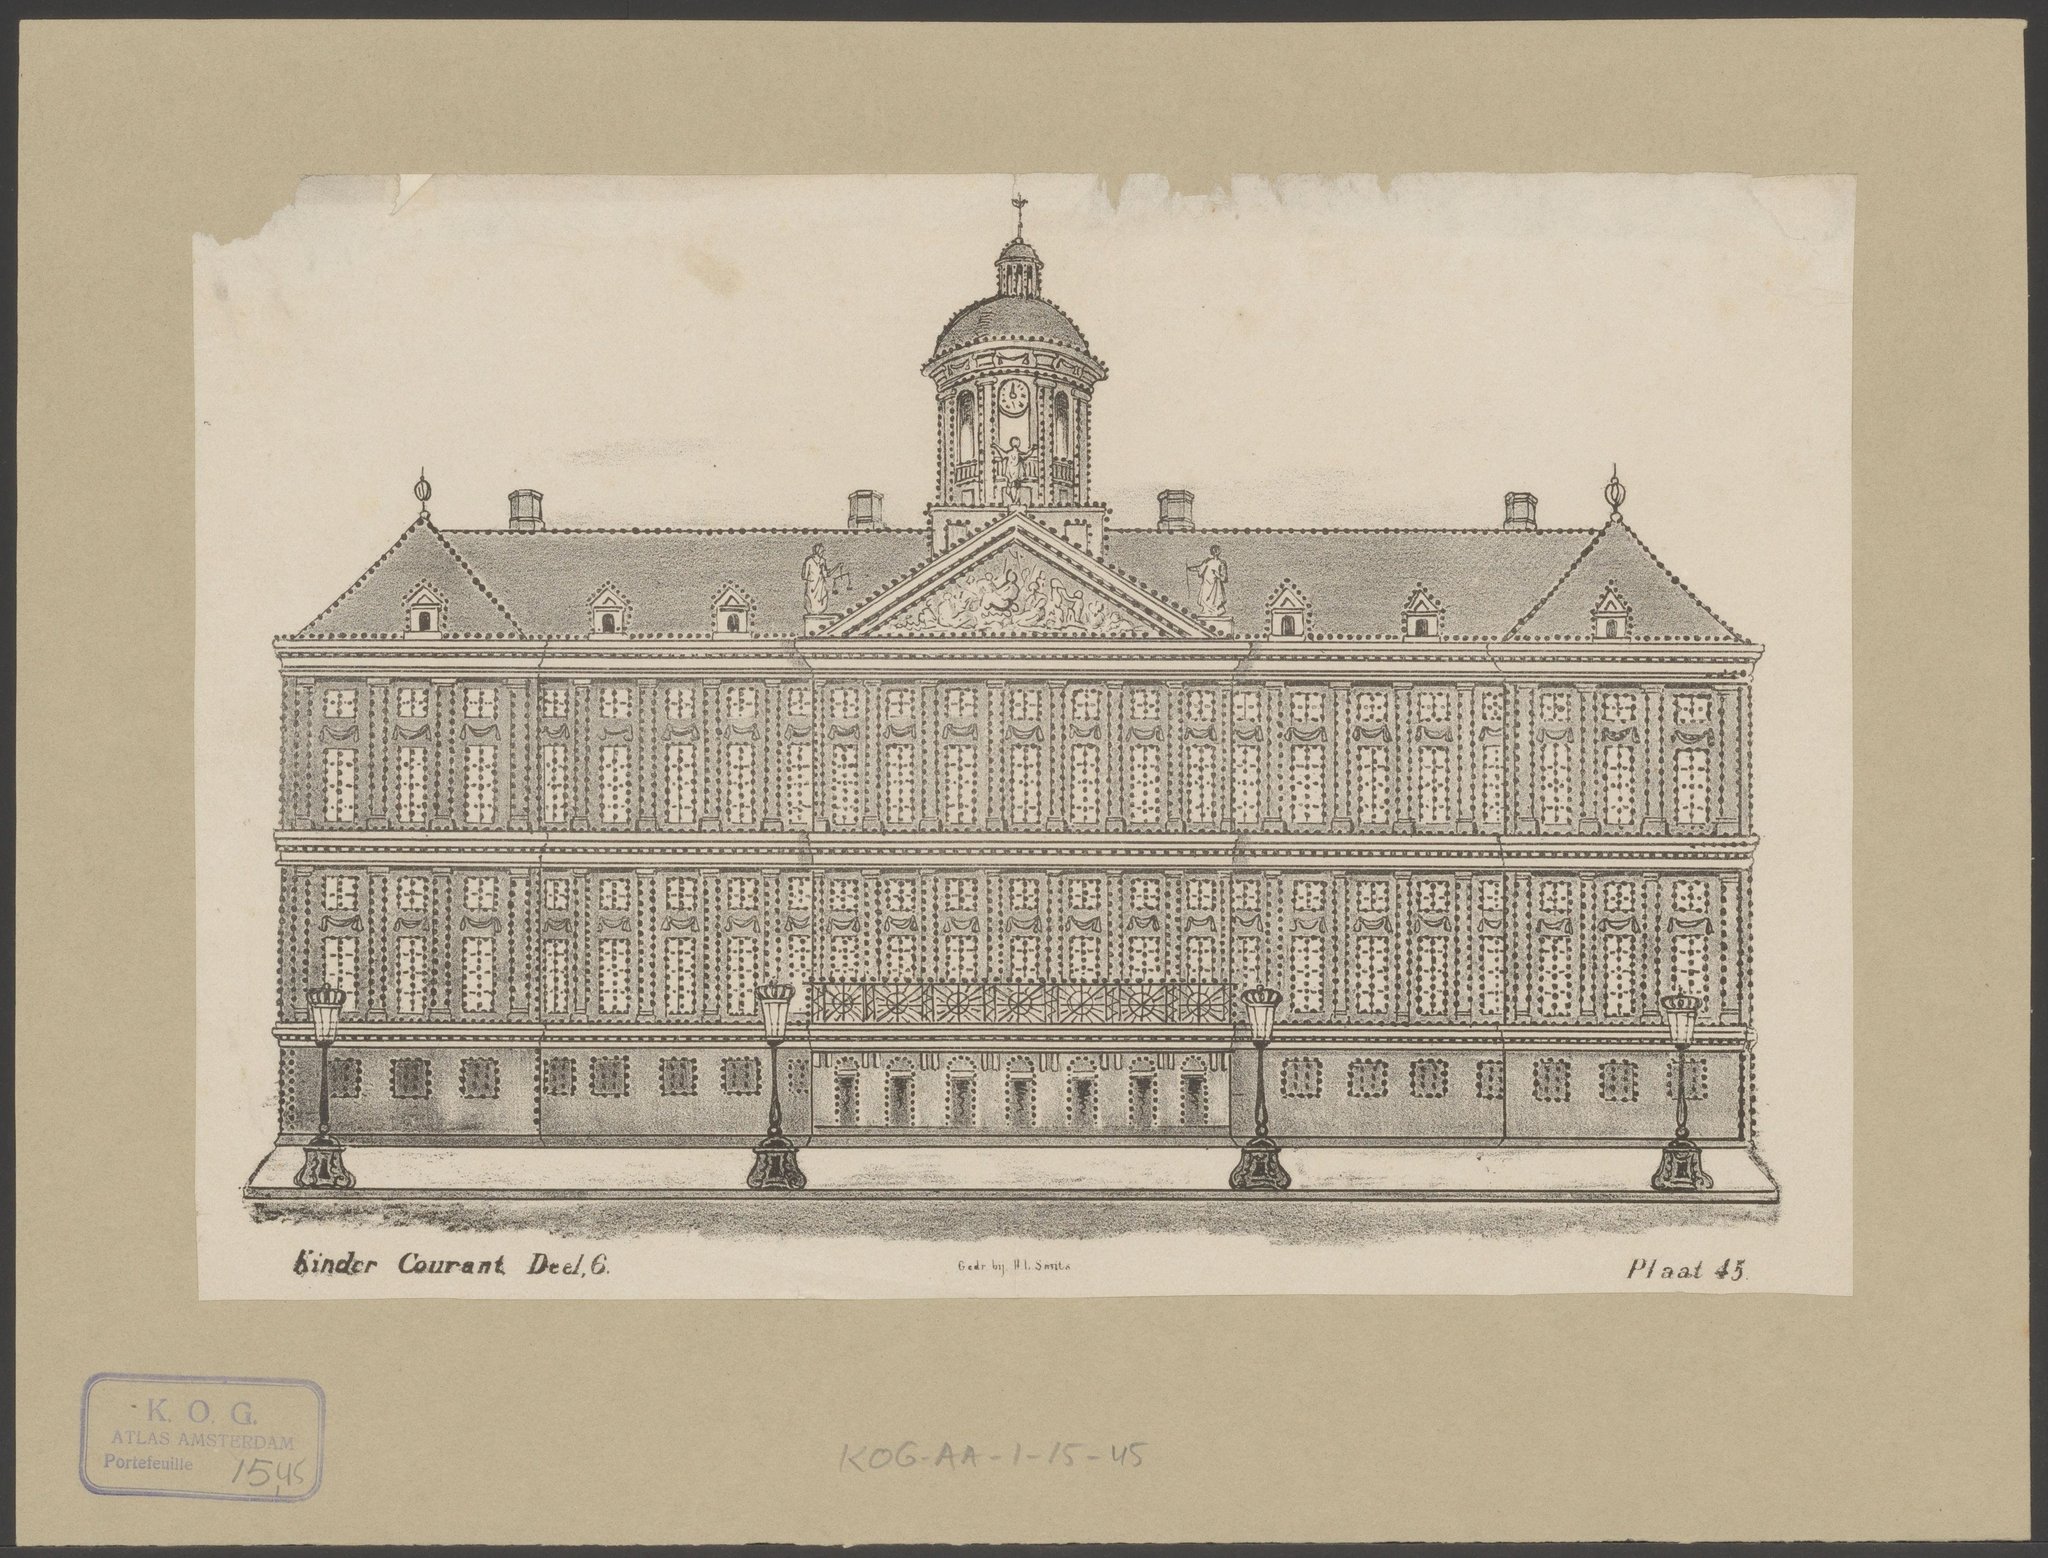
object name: print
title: Gezicht op het Paleis op de Dam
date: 1852-1905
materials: paper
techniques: lithograph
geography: the hague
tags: city-view in general; 'veduta', townhall, façade (of house or building)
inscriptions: collector's mark: ‘15,45’ Lugt 1641b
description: Onderwerpsrubriek binnen de Atlas Amsterdam: Nieuwe Stadhuis, als Paleis, op de Dam, van Buiten. Linksonder: Deel 6. Rechtsonder: Plaat 45.